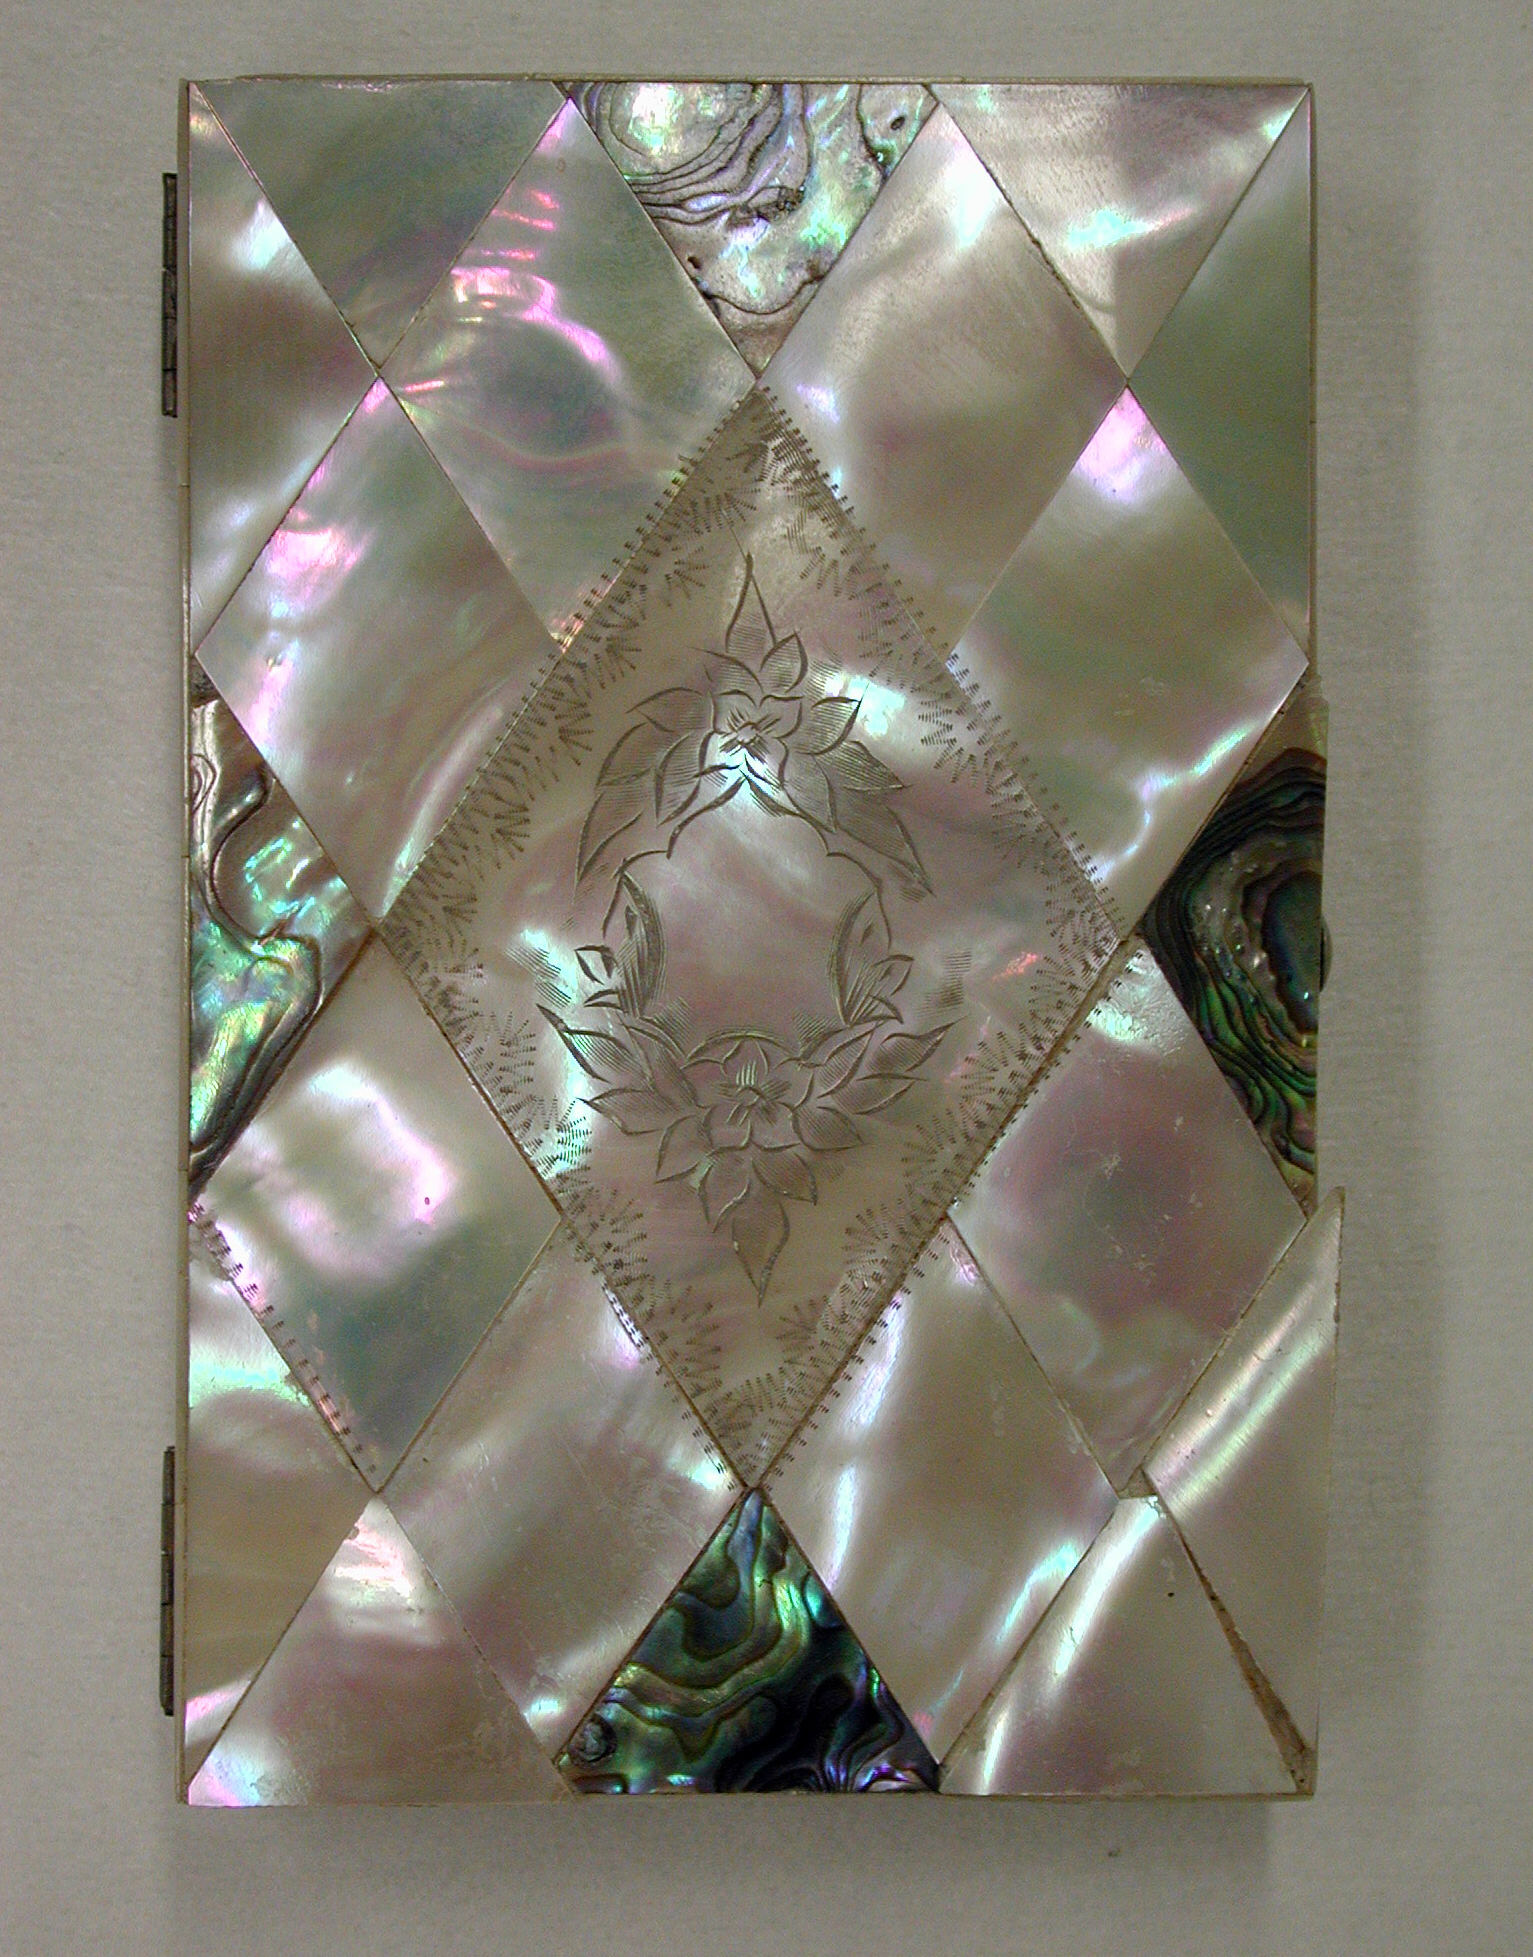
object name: card case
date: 1860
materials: mother of pearl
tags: flowers